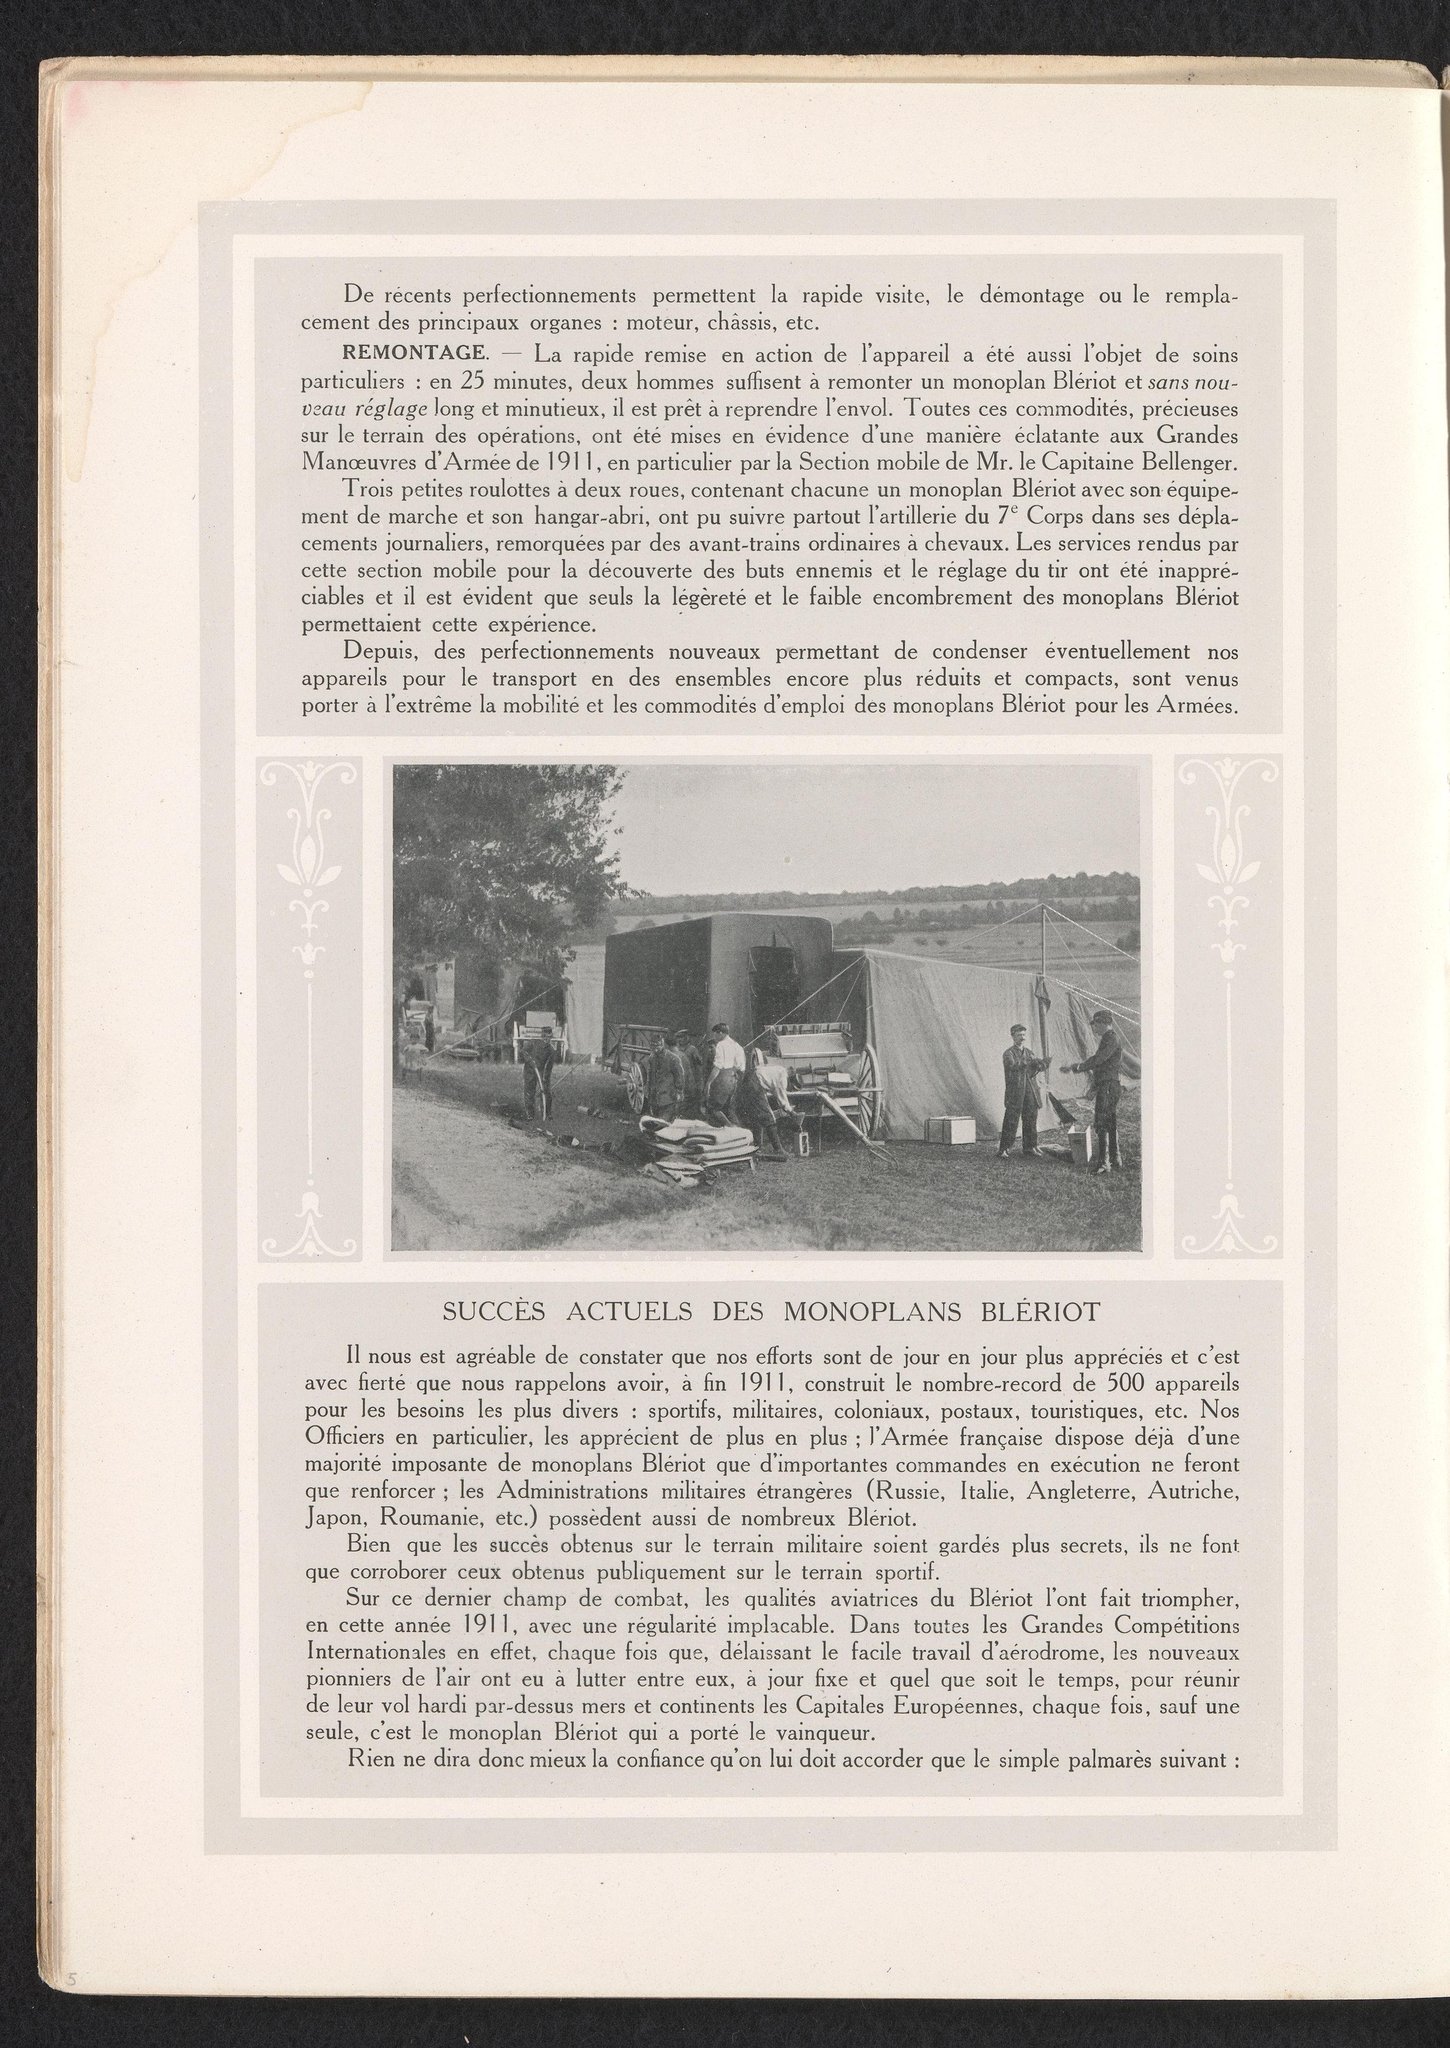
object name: photomechanical print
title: Tentenkamp op open veld voor bemanning en apparatuur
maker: Anonymous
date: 1907-1912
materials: paper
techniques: autotype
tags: aircraft, aeroplane, flight crew, tent-camp, plain